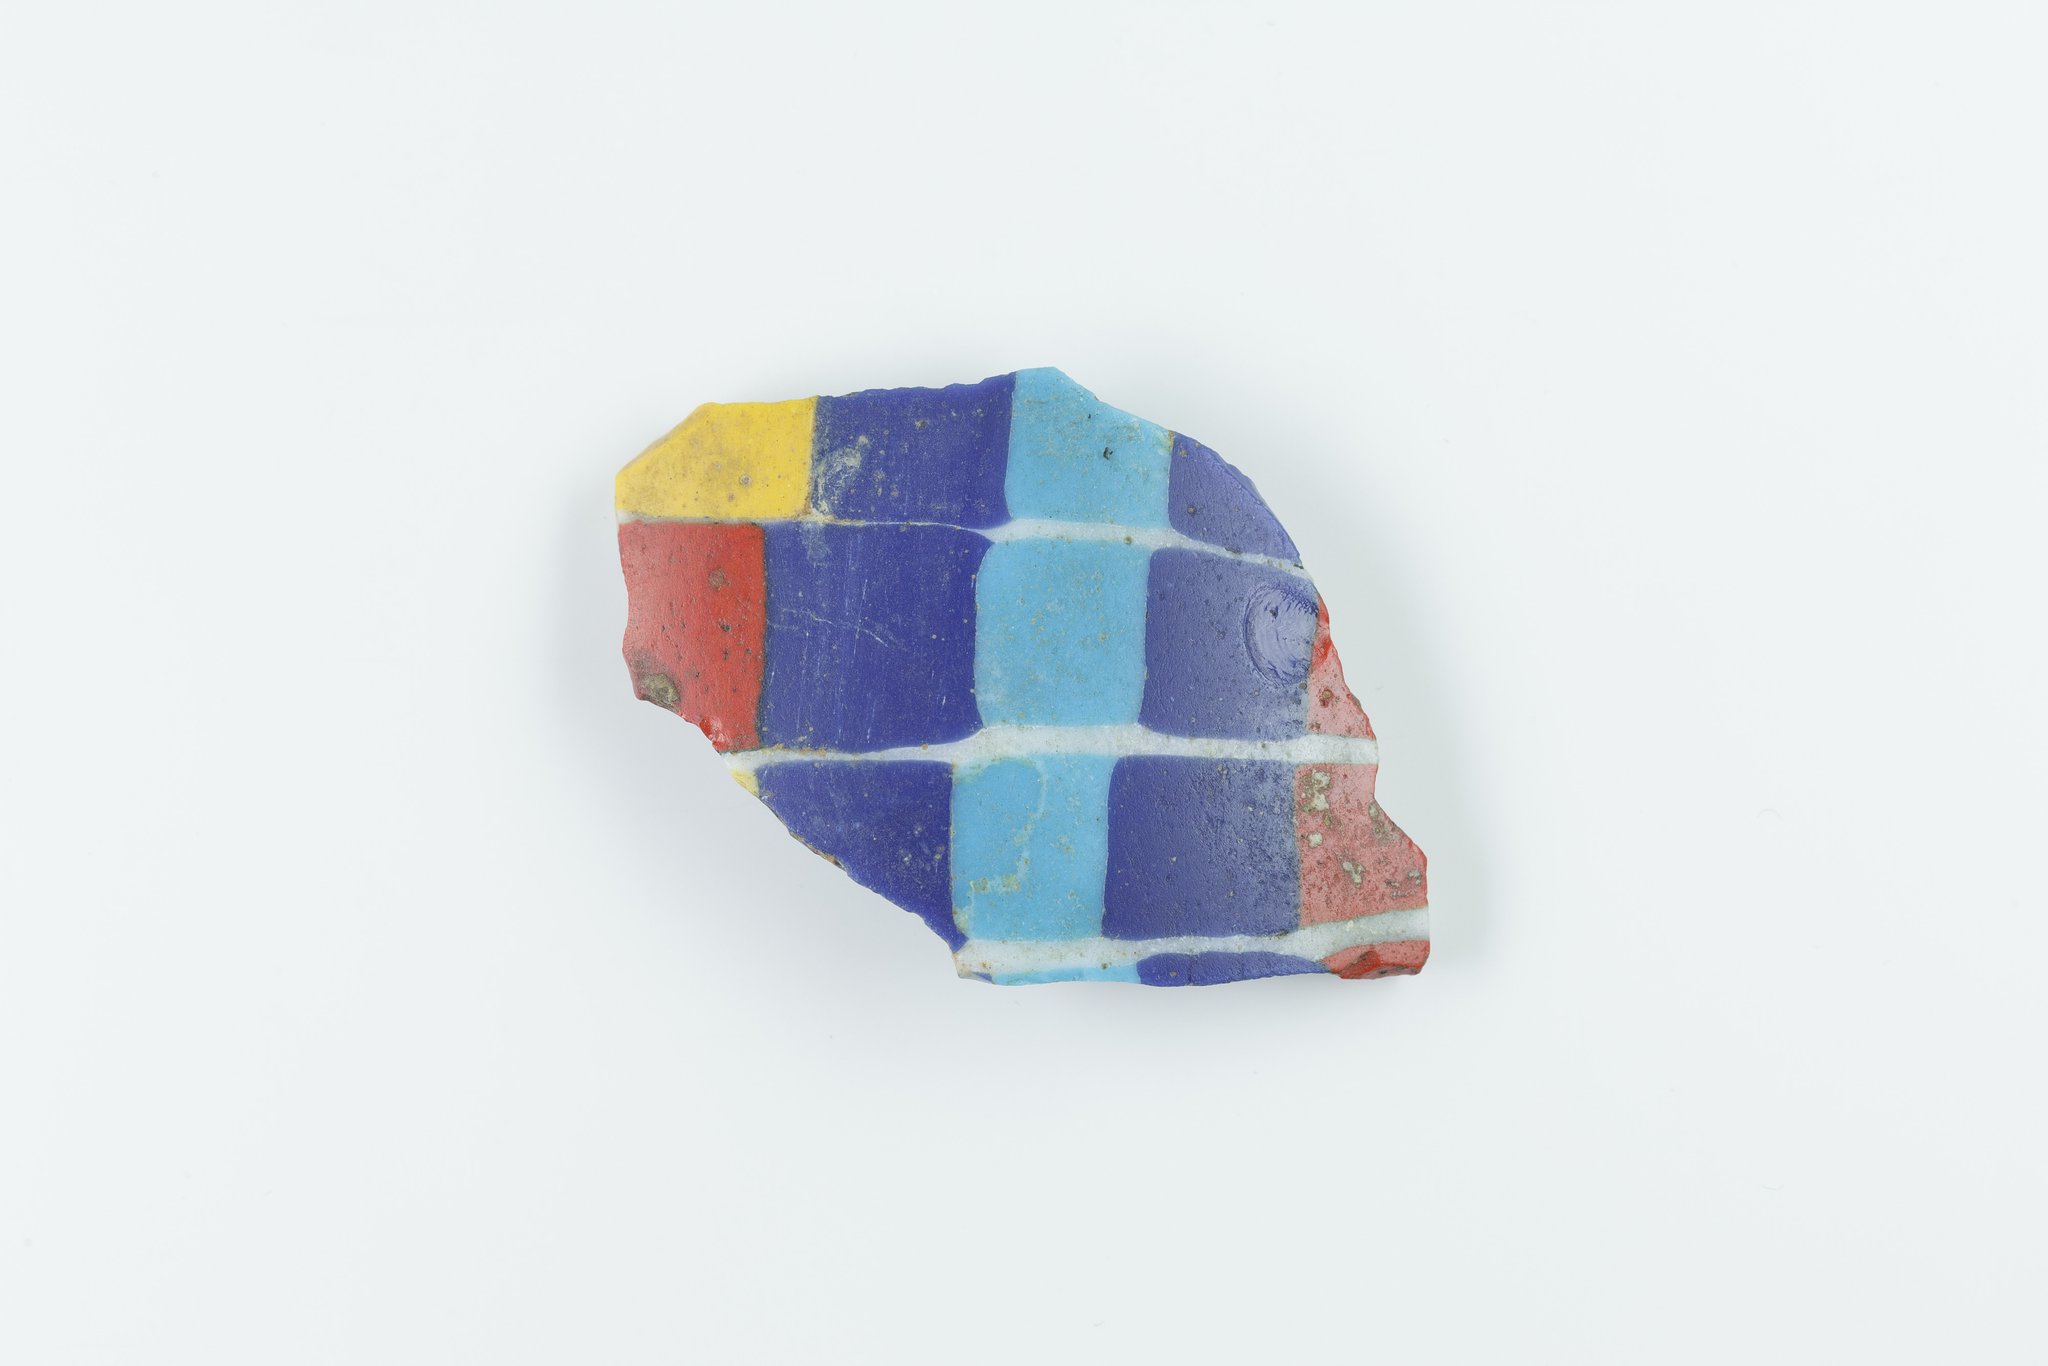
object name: fragment, mosaic bowl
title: Fragment from a Mosaic Bowl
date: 1427-1400 BCE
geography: upper egypt, thebes